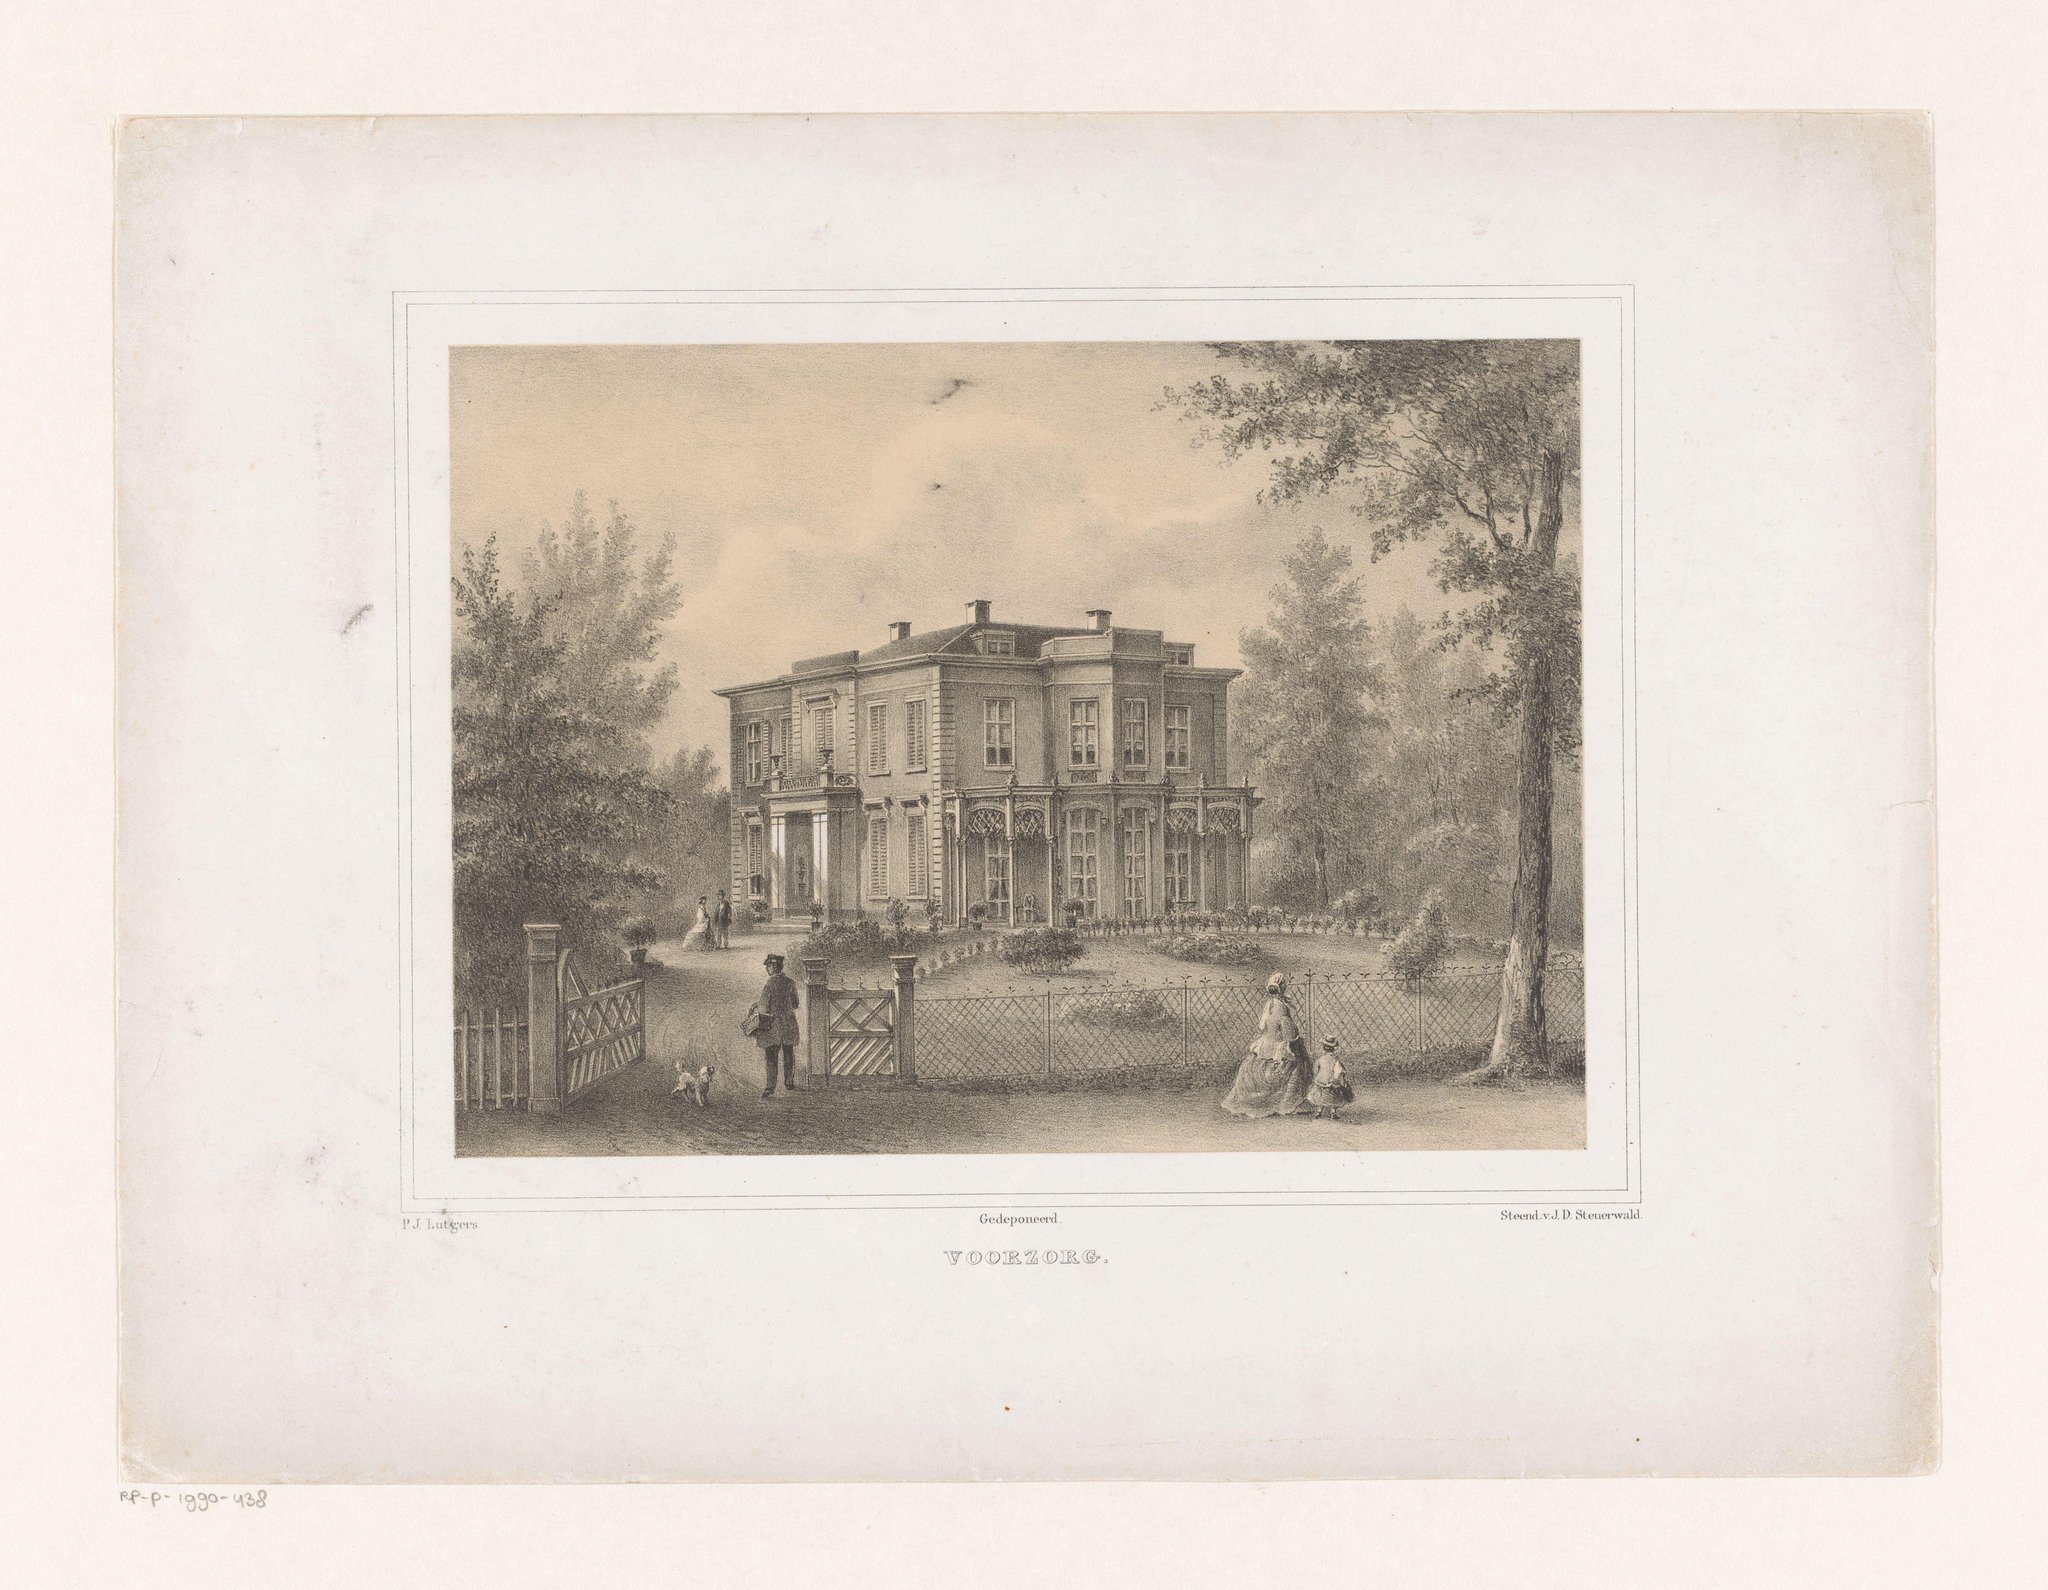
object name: print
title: Gezigten in de omstreken van Utrecht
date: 1869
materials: paper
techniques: tone lithography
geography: loenen aan de vecht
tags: country-house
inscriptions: collector's mark: Lugt 2228, : ‘Gedeponeerd.’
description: In de voorgrond lopen figuren en een hond.